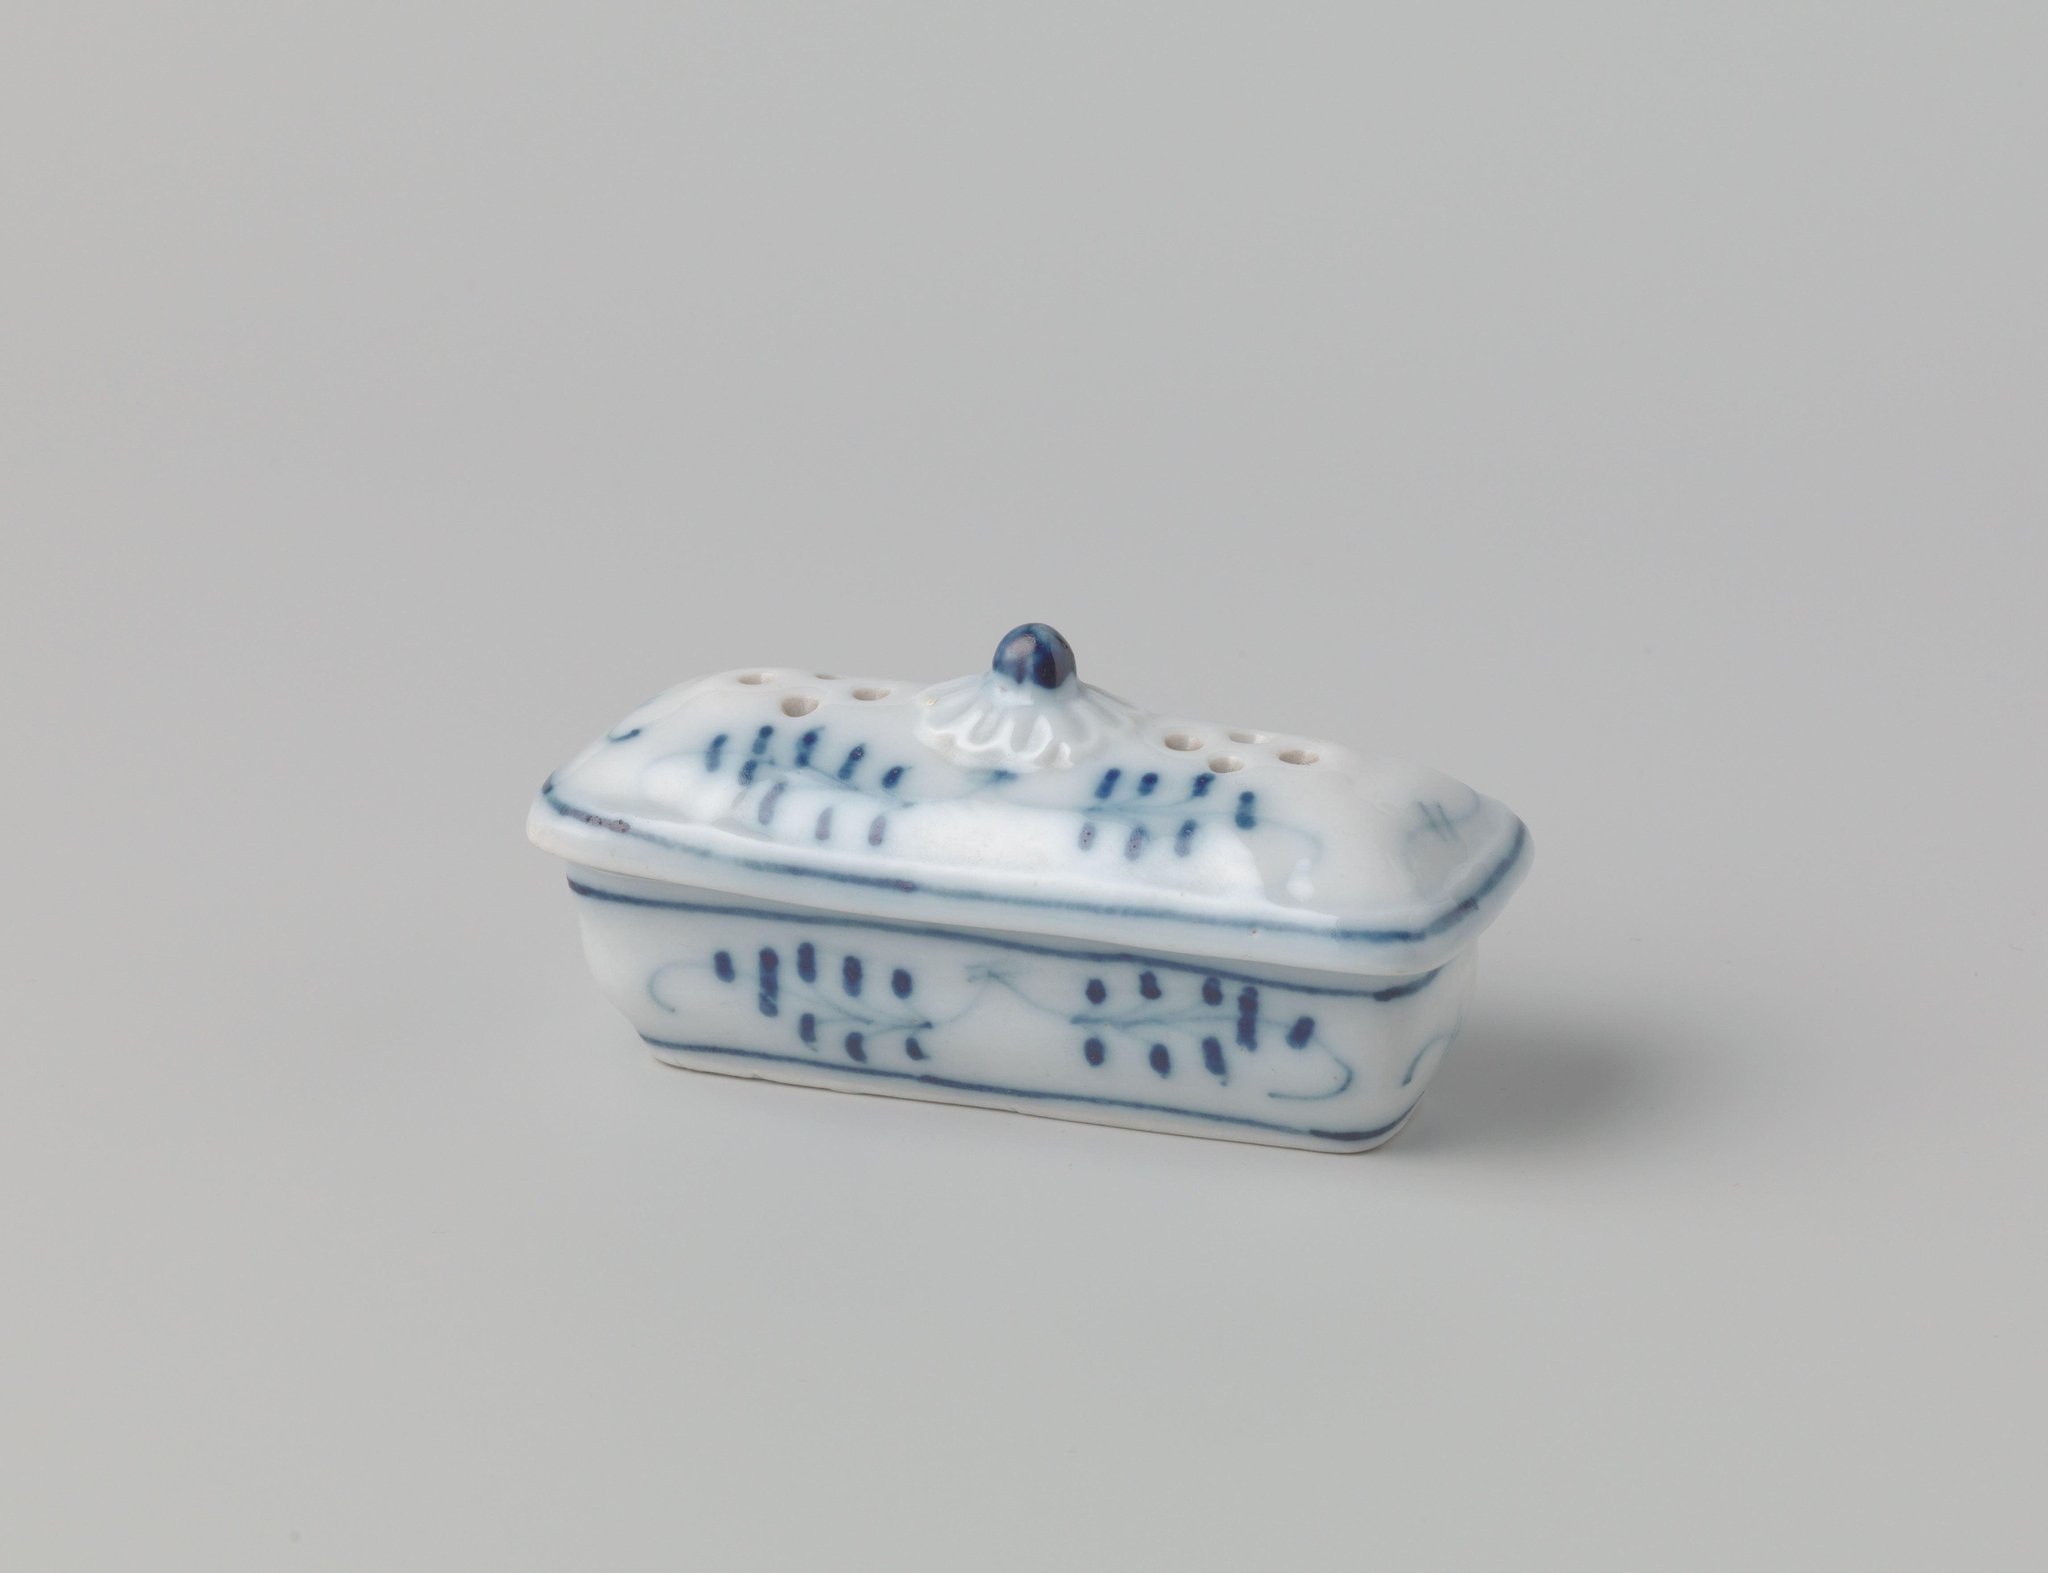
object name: wastafelservies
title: Tandenschuierbakje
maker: Anonymous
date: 1775-1800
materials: ceramic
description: Tandenschuierbakje met blauw Saksisch patroon, ongemerkt.